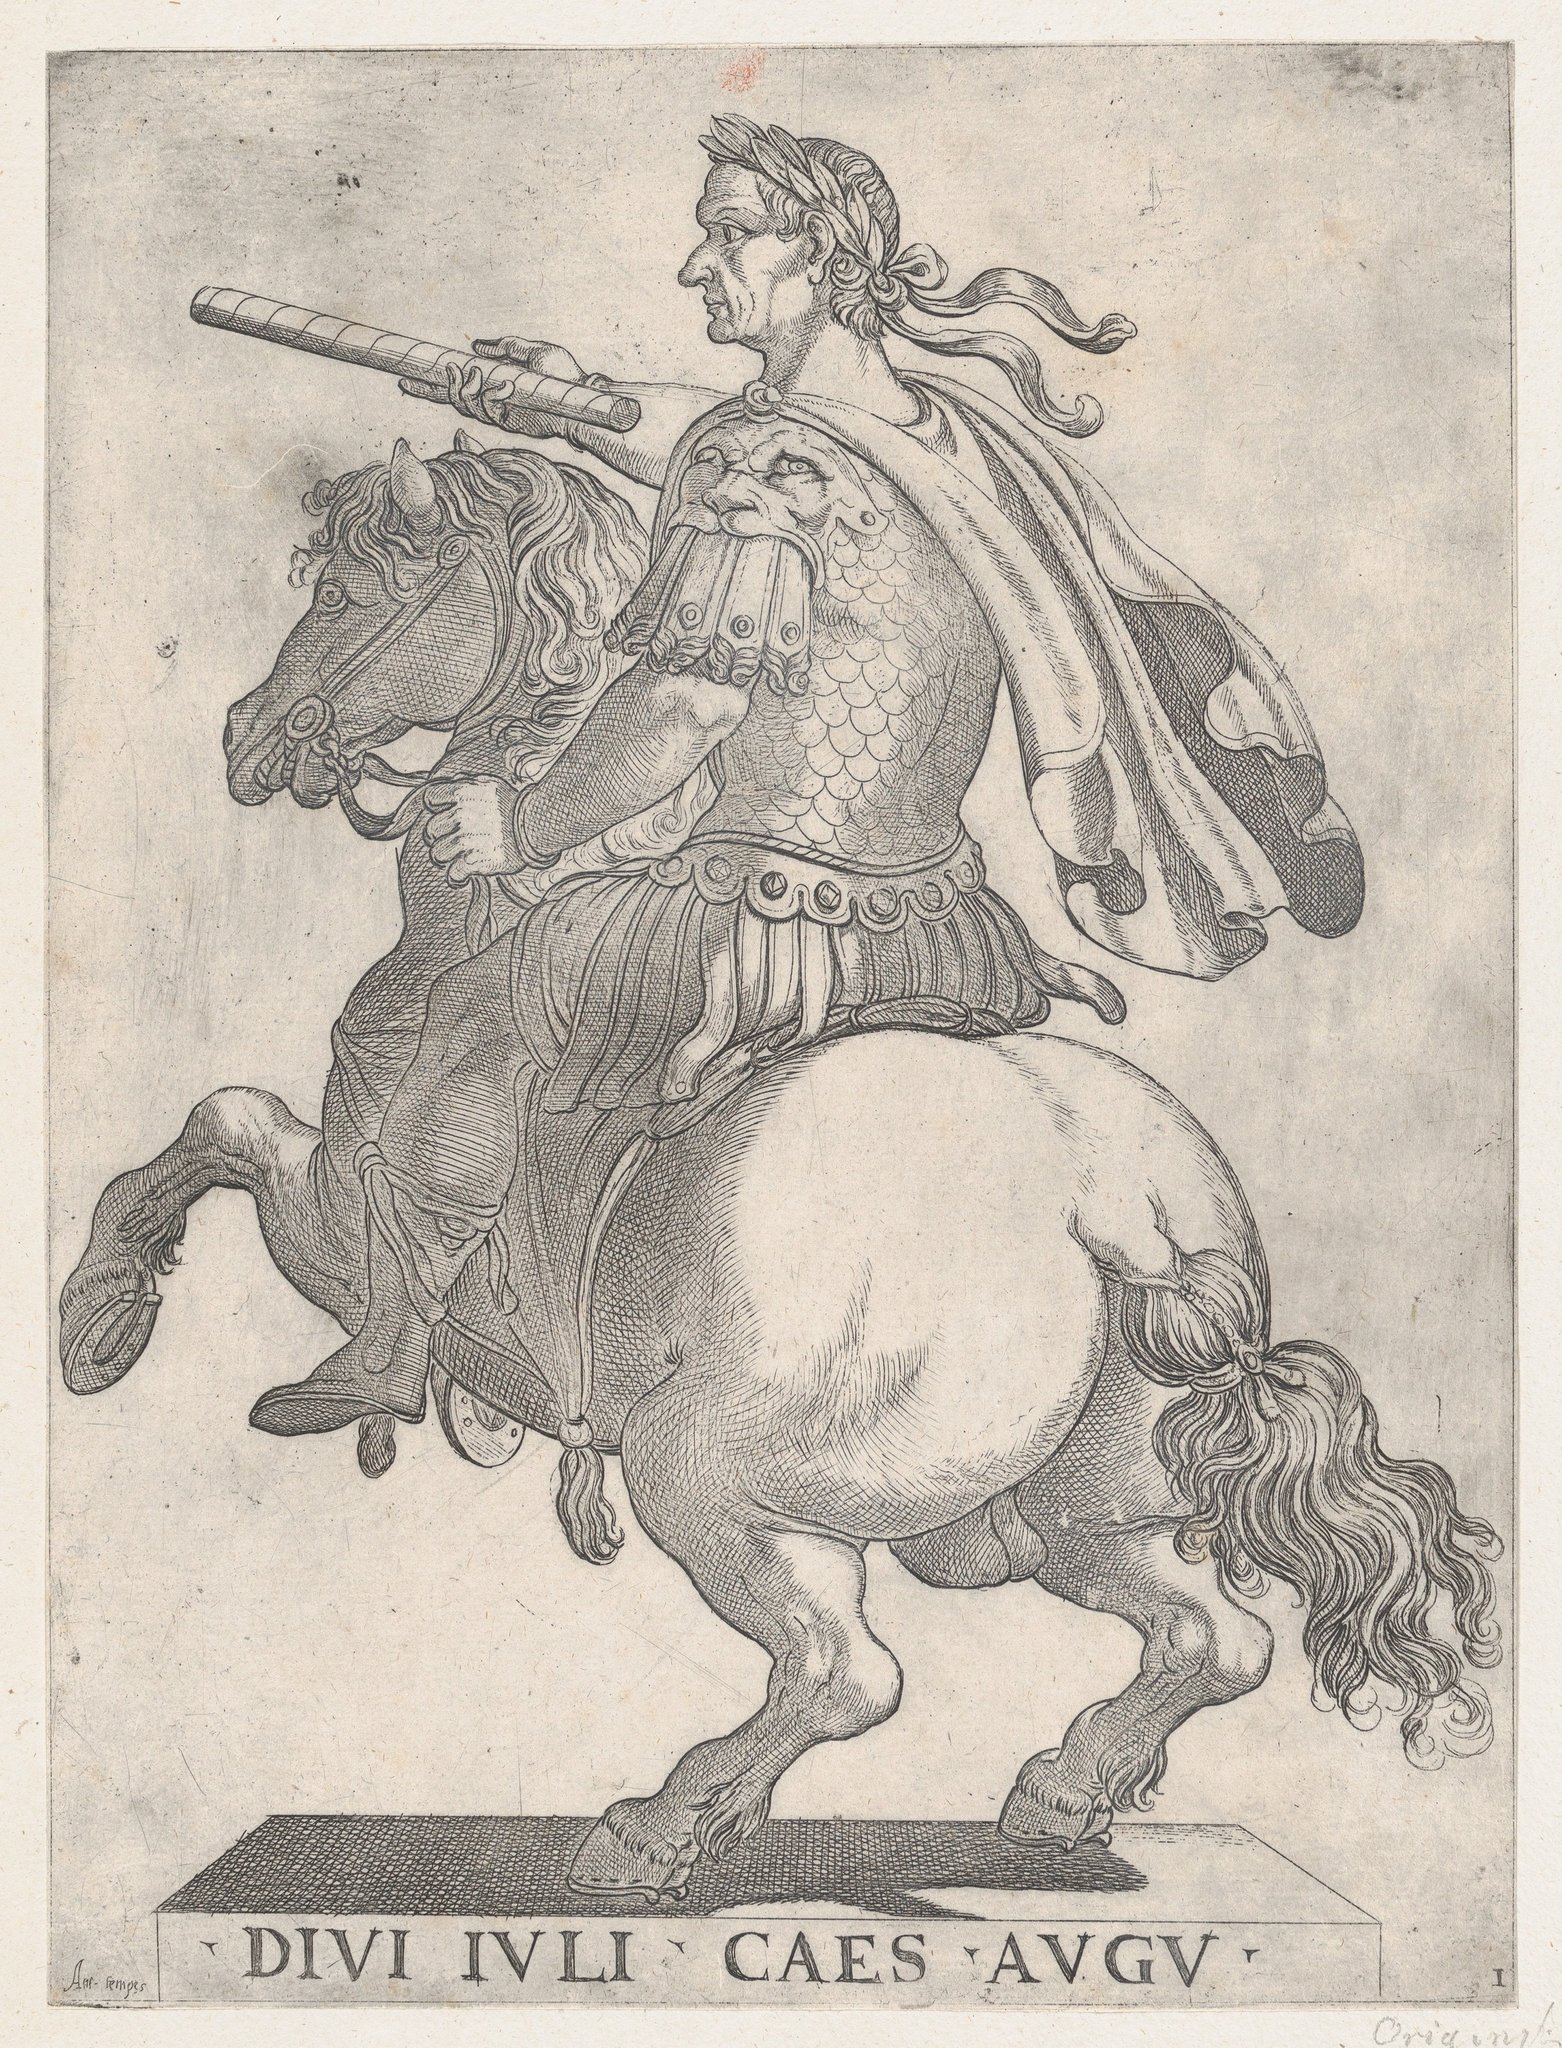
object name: print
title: Plate 1: Emperor Julius Caesar on Horseback, from 'The First Twelve Roman Caesars'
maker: antonio tempesta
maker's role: artist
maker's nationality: italian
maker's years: 1555-1630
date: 1596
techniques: etching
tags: julius caesar,horses